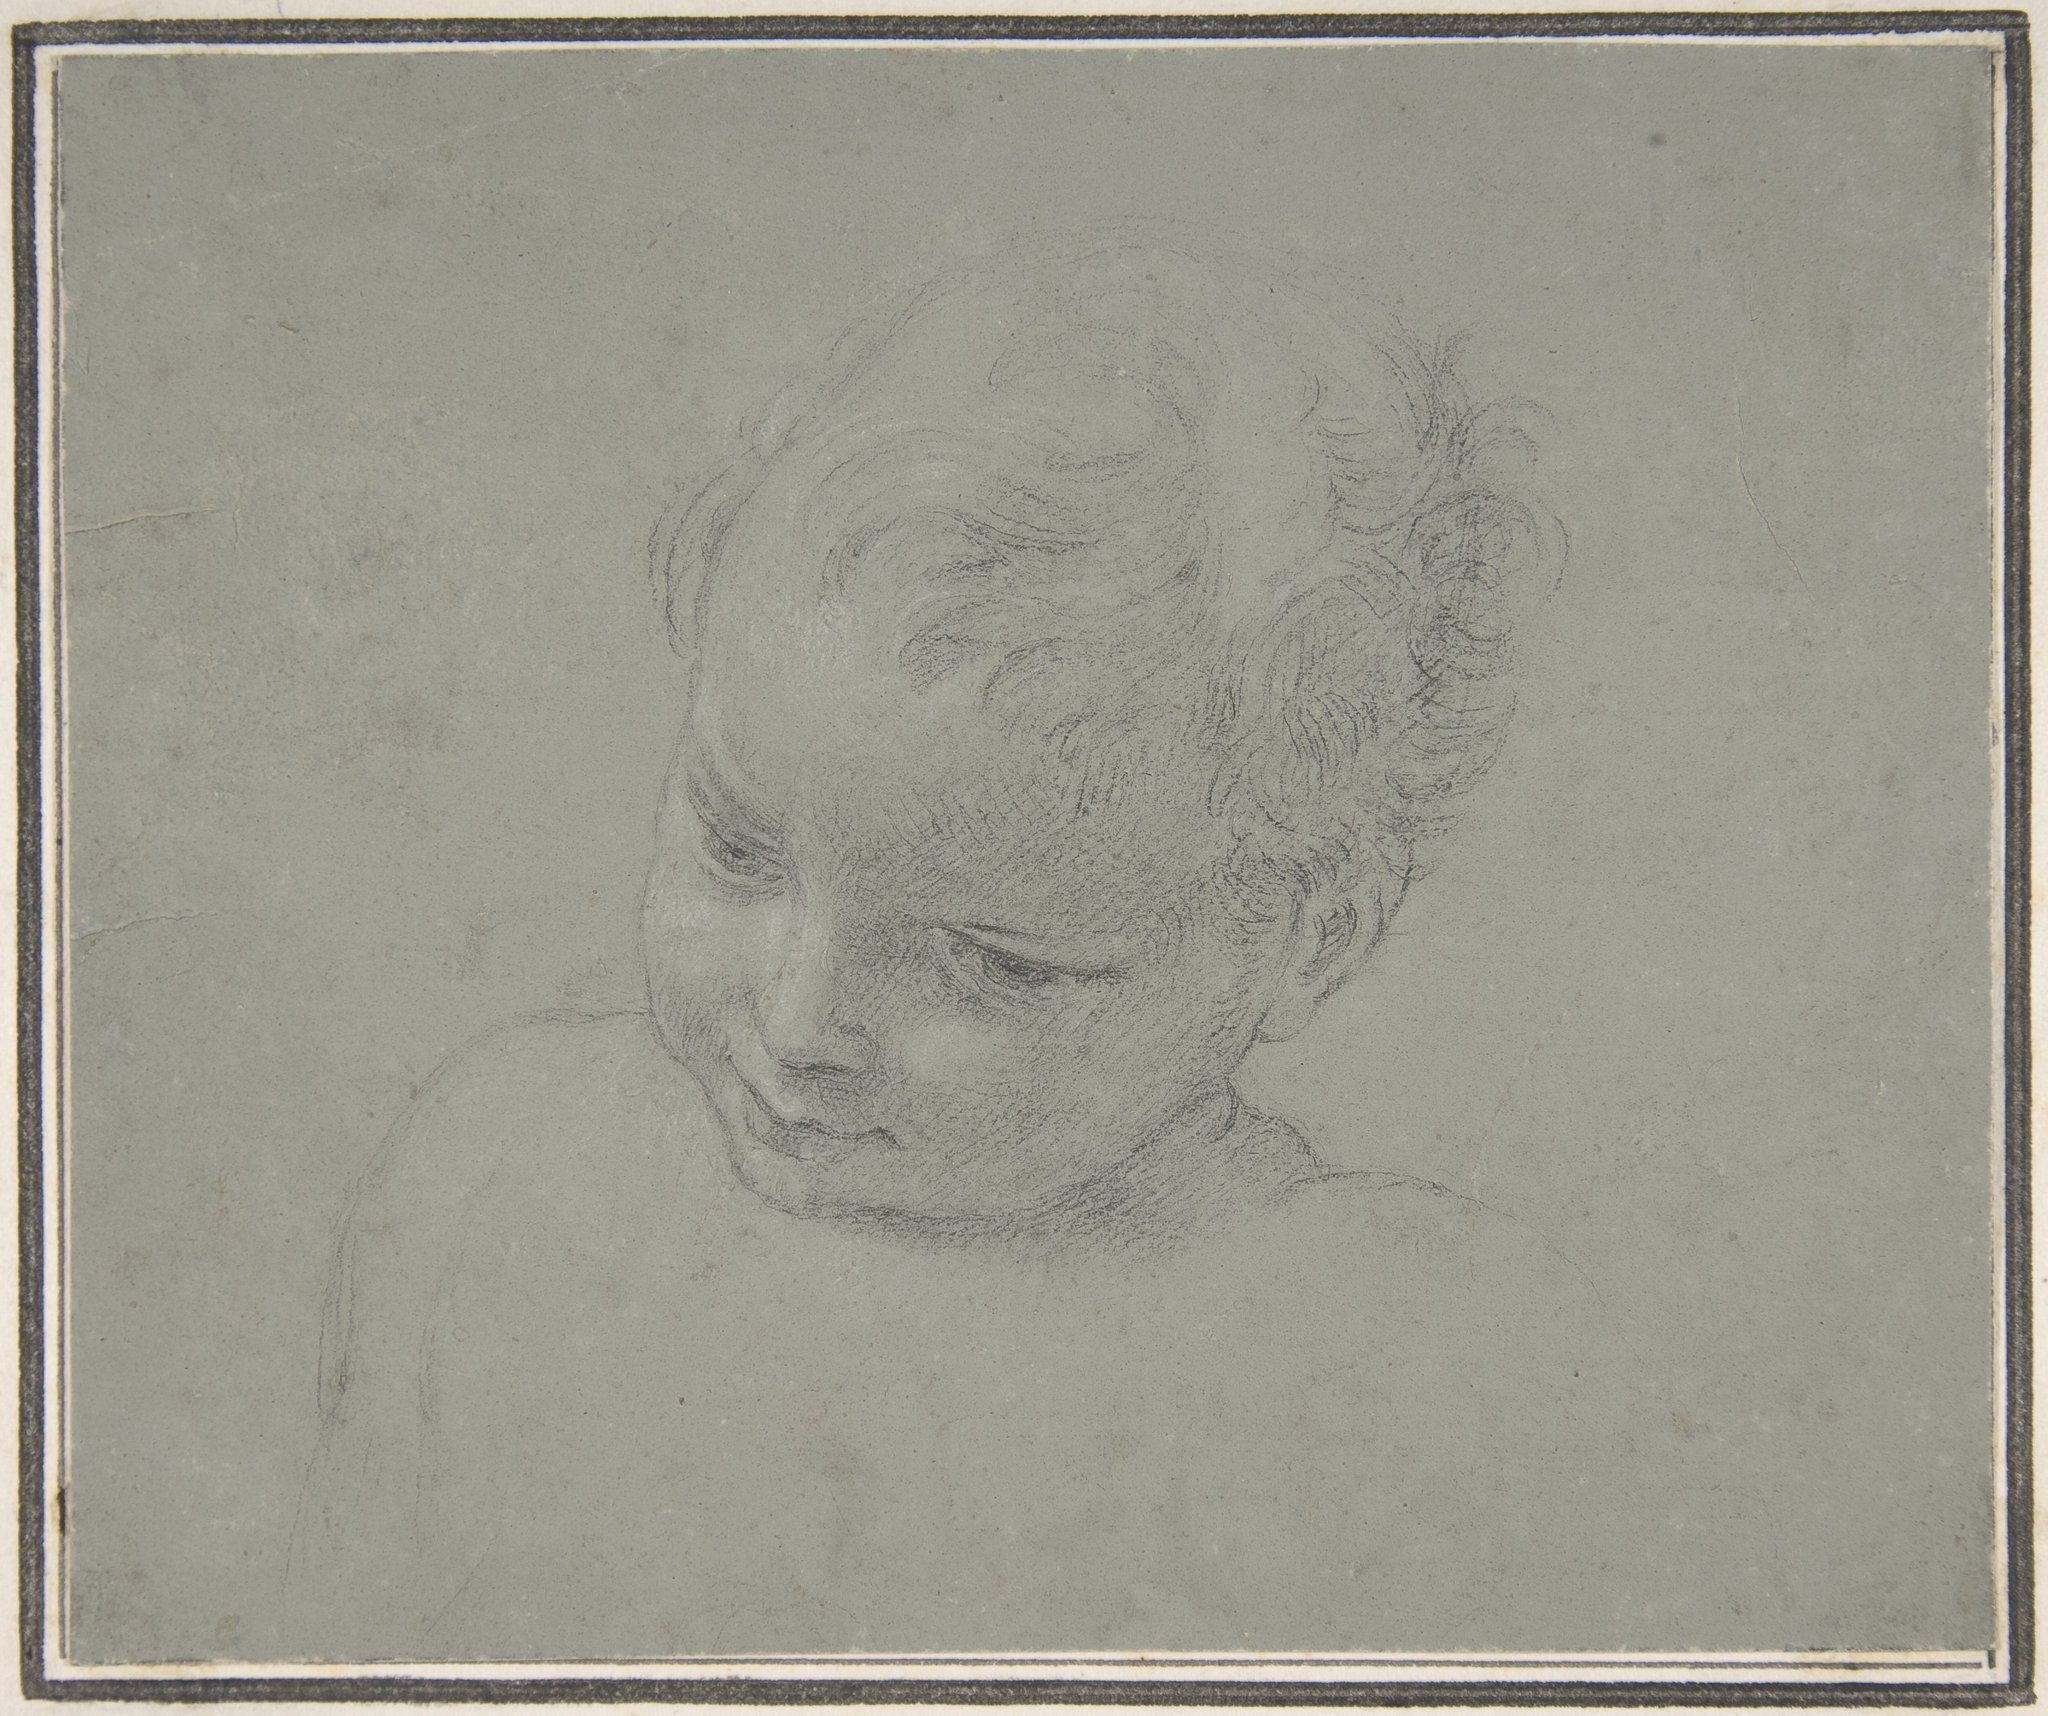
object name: drawing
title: Bust-Length Study of a Child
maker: pompeo batoni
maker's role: artist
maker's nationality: italian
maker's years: 1708-1787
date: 1708-1787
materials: chalk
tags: children